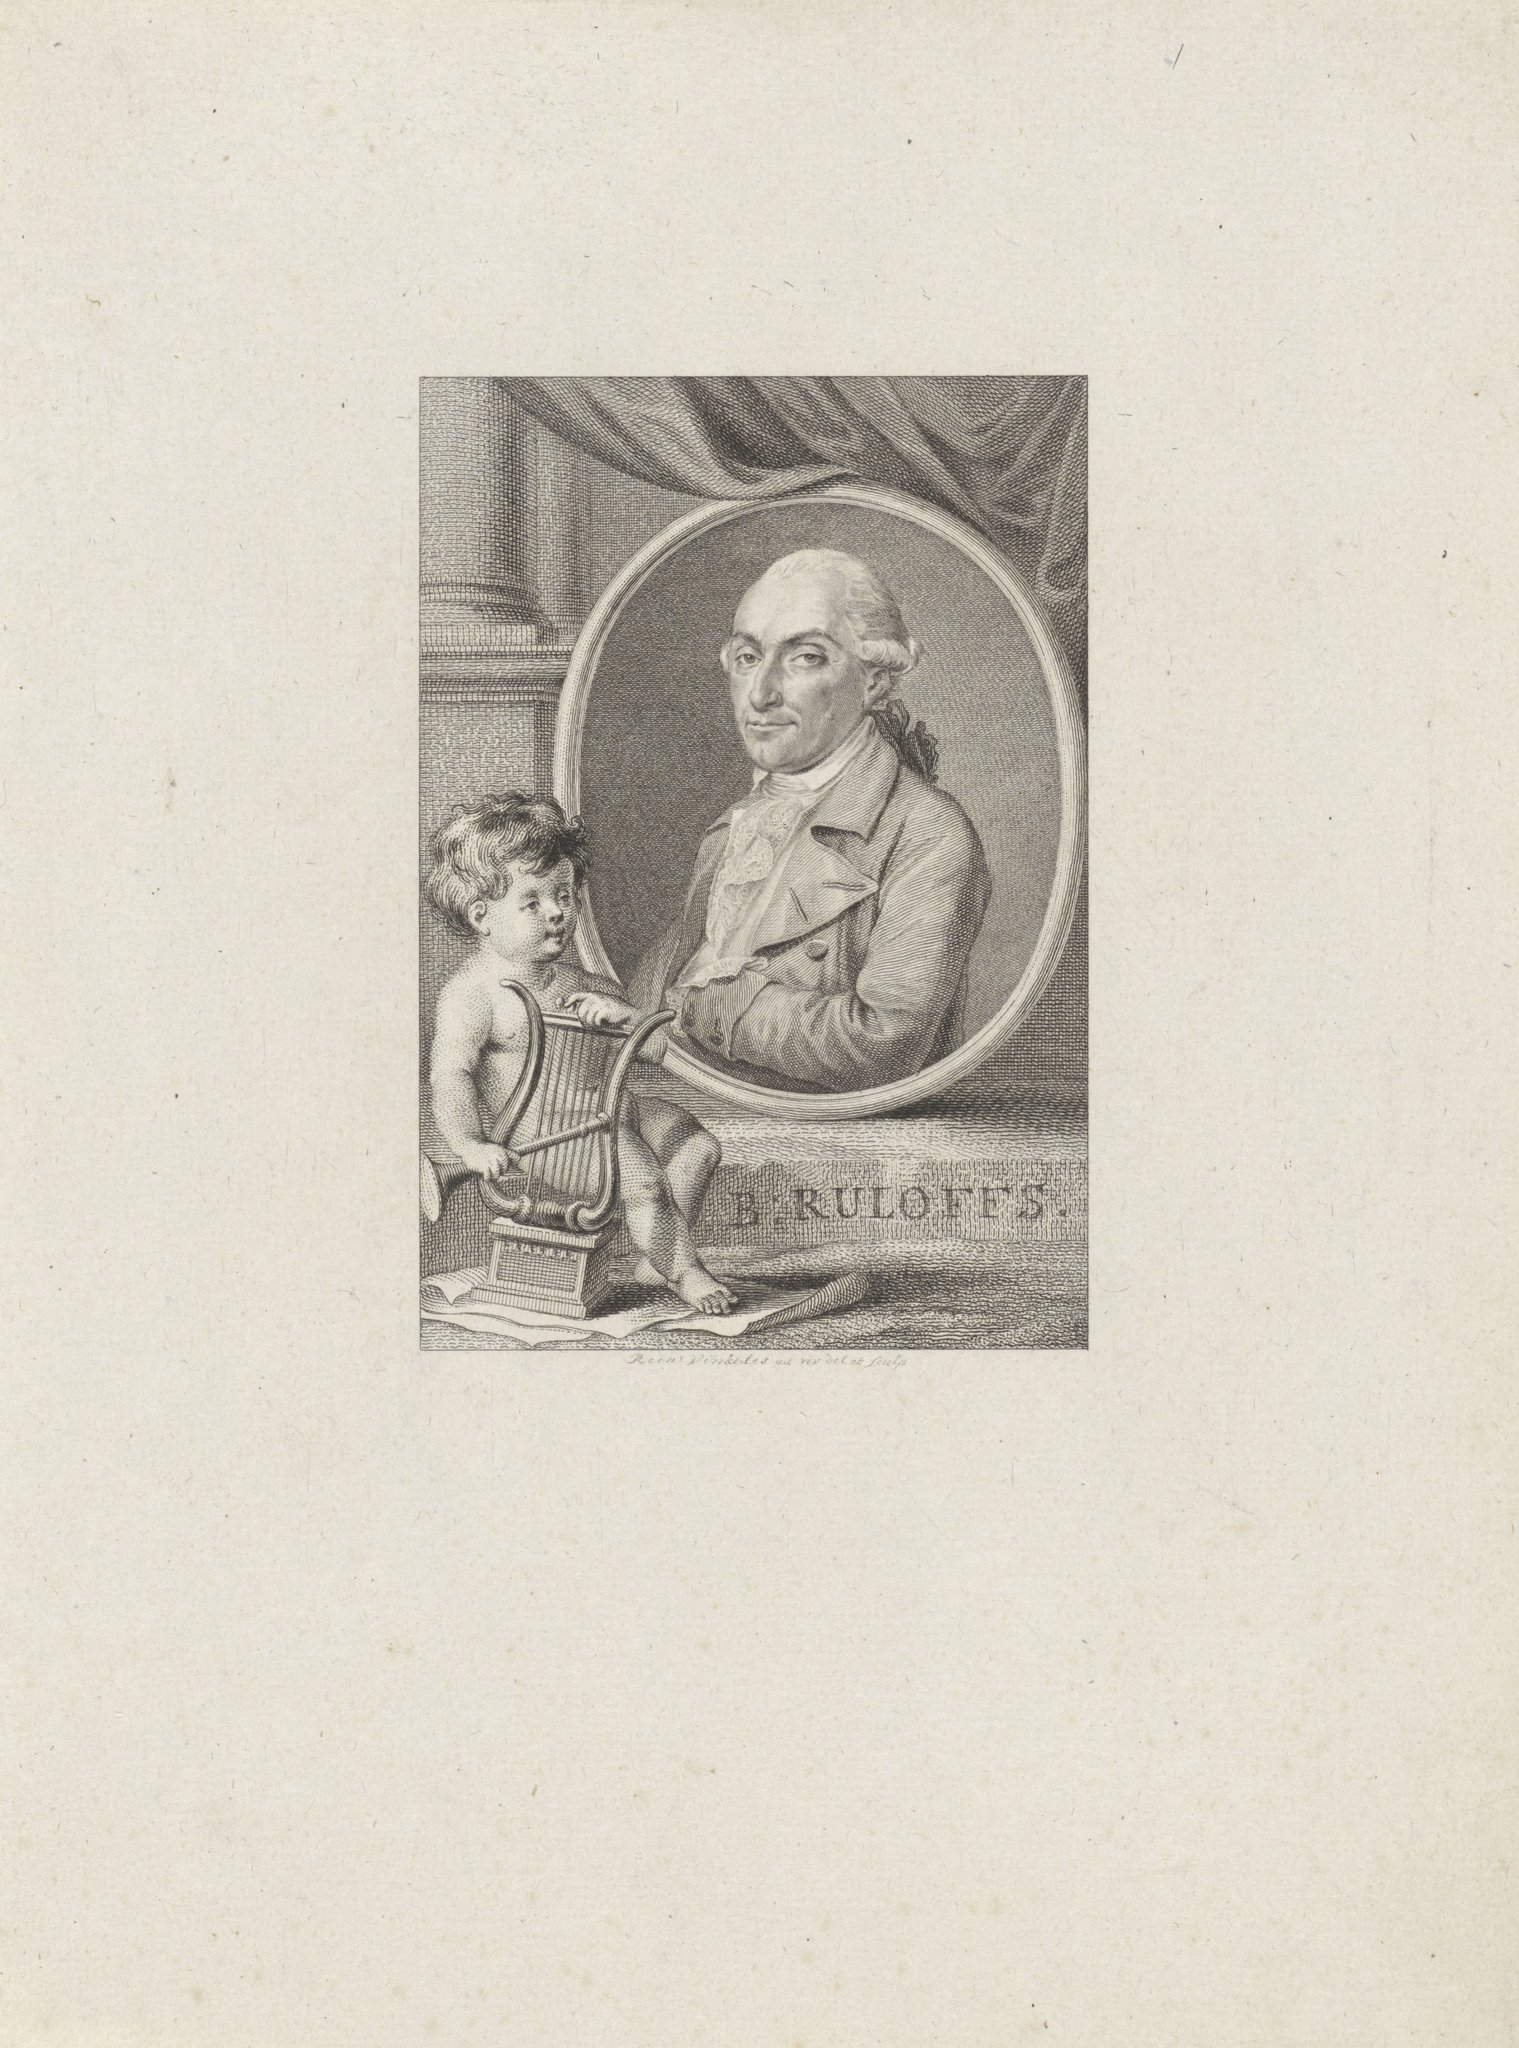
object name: print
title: Portret van Bartholomeus Ruloffs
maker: reinier vinkeles (i)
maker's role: draughtsman, print maker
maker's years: 1741-1816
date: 1751-1816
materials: paper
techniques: engraving, etching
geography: amsterdam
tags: amsterdam, bartholomeus ruloffs, lyre, cithara, psaltery, horn, trumpet, cornet, trombone, tuba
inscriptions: collector's mark: Lugt 240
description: Portret van de Amsterdamse muziekmeester en dichter Bartholomeus Ruloffs. Onder het portret een putto met een bazuin en een lier.